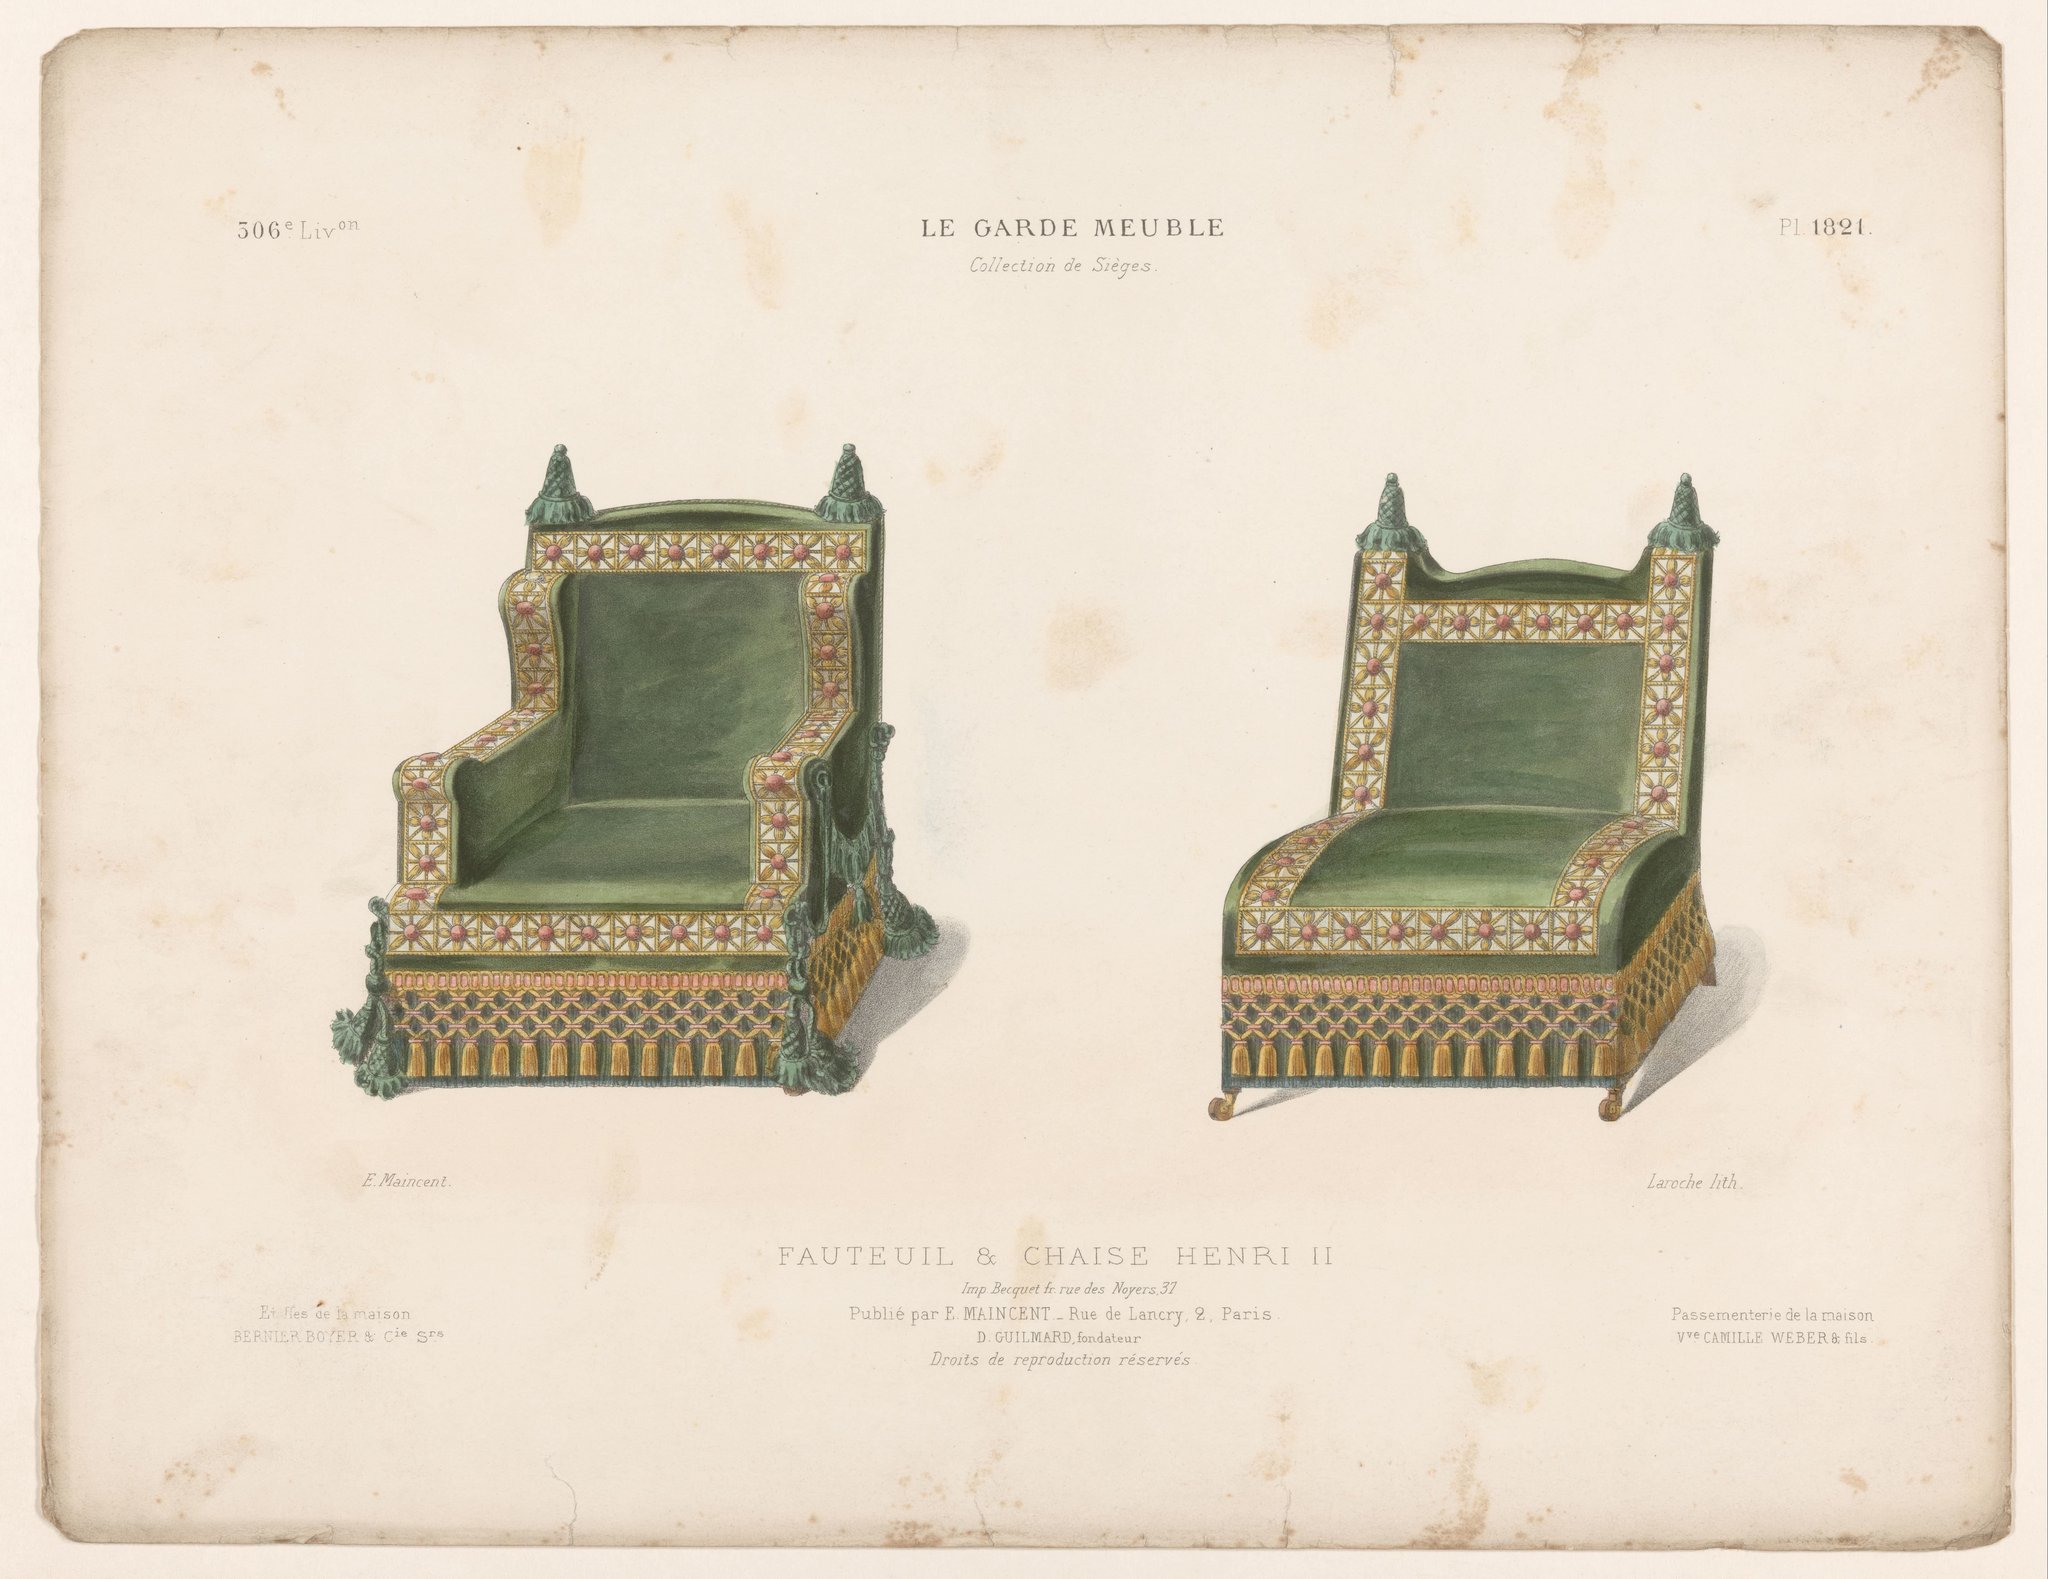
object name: print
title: Fauteuil en stoel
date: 1885-1895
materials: paper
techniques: hand coloring, lithograph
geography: paris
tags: seating furniture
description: Ieder Livraison in de serie Le Garde-Meuble bevat negen platen: drie 'sièges' (zitmeubels), drie 'meubles' (diverse meubels zoals tafels en kasten) en drie 'tentures' (gordijnen en draperieën).